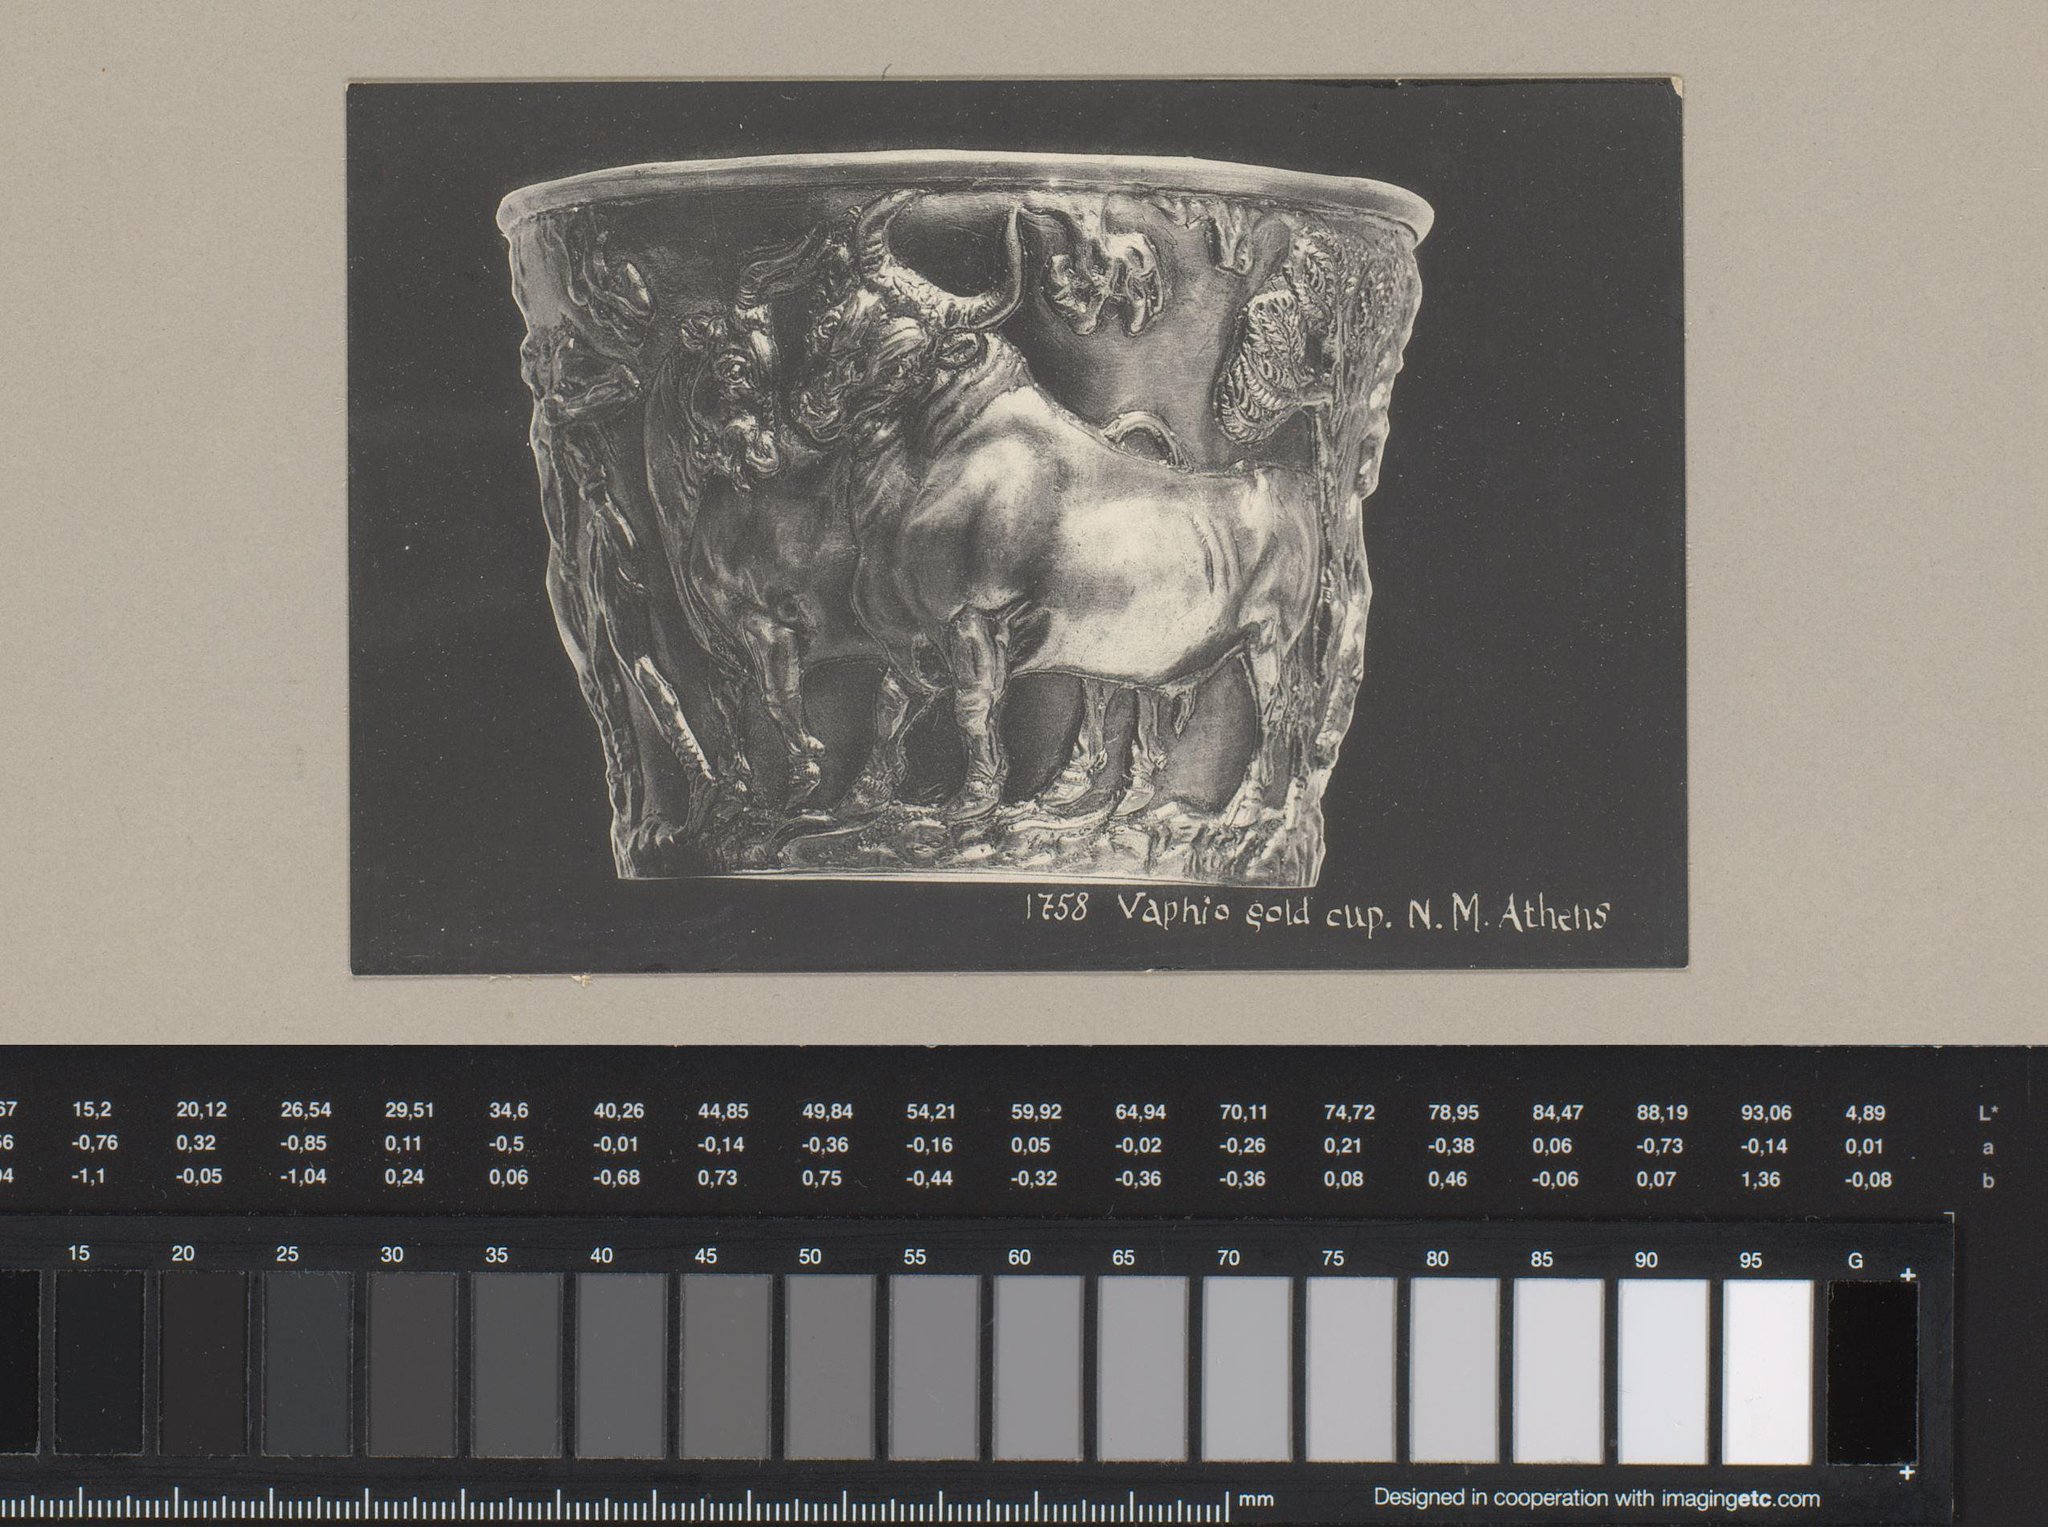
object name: photograph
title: 1758 Vaphio gold cup. N.M. Athens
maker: Anonymous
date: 1895-1915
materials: cardboard, paper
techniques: photograph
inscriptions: number: ‘64.’